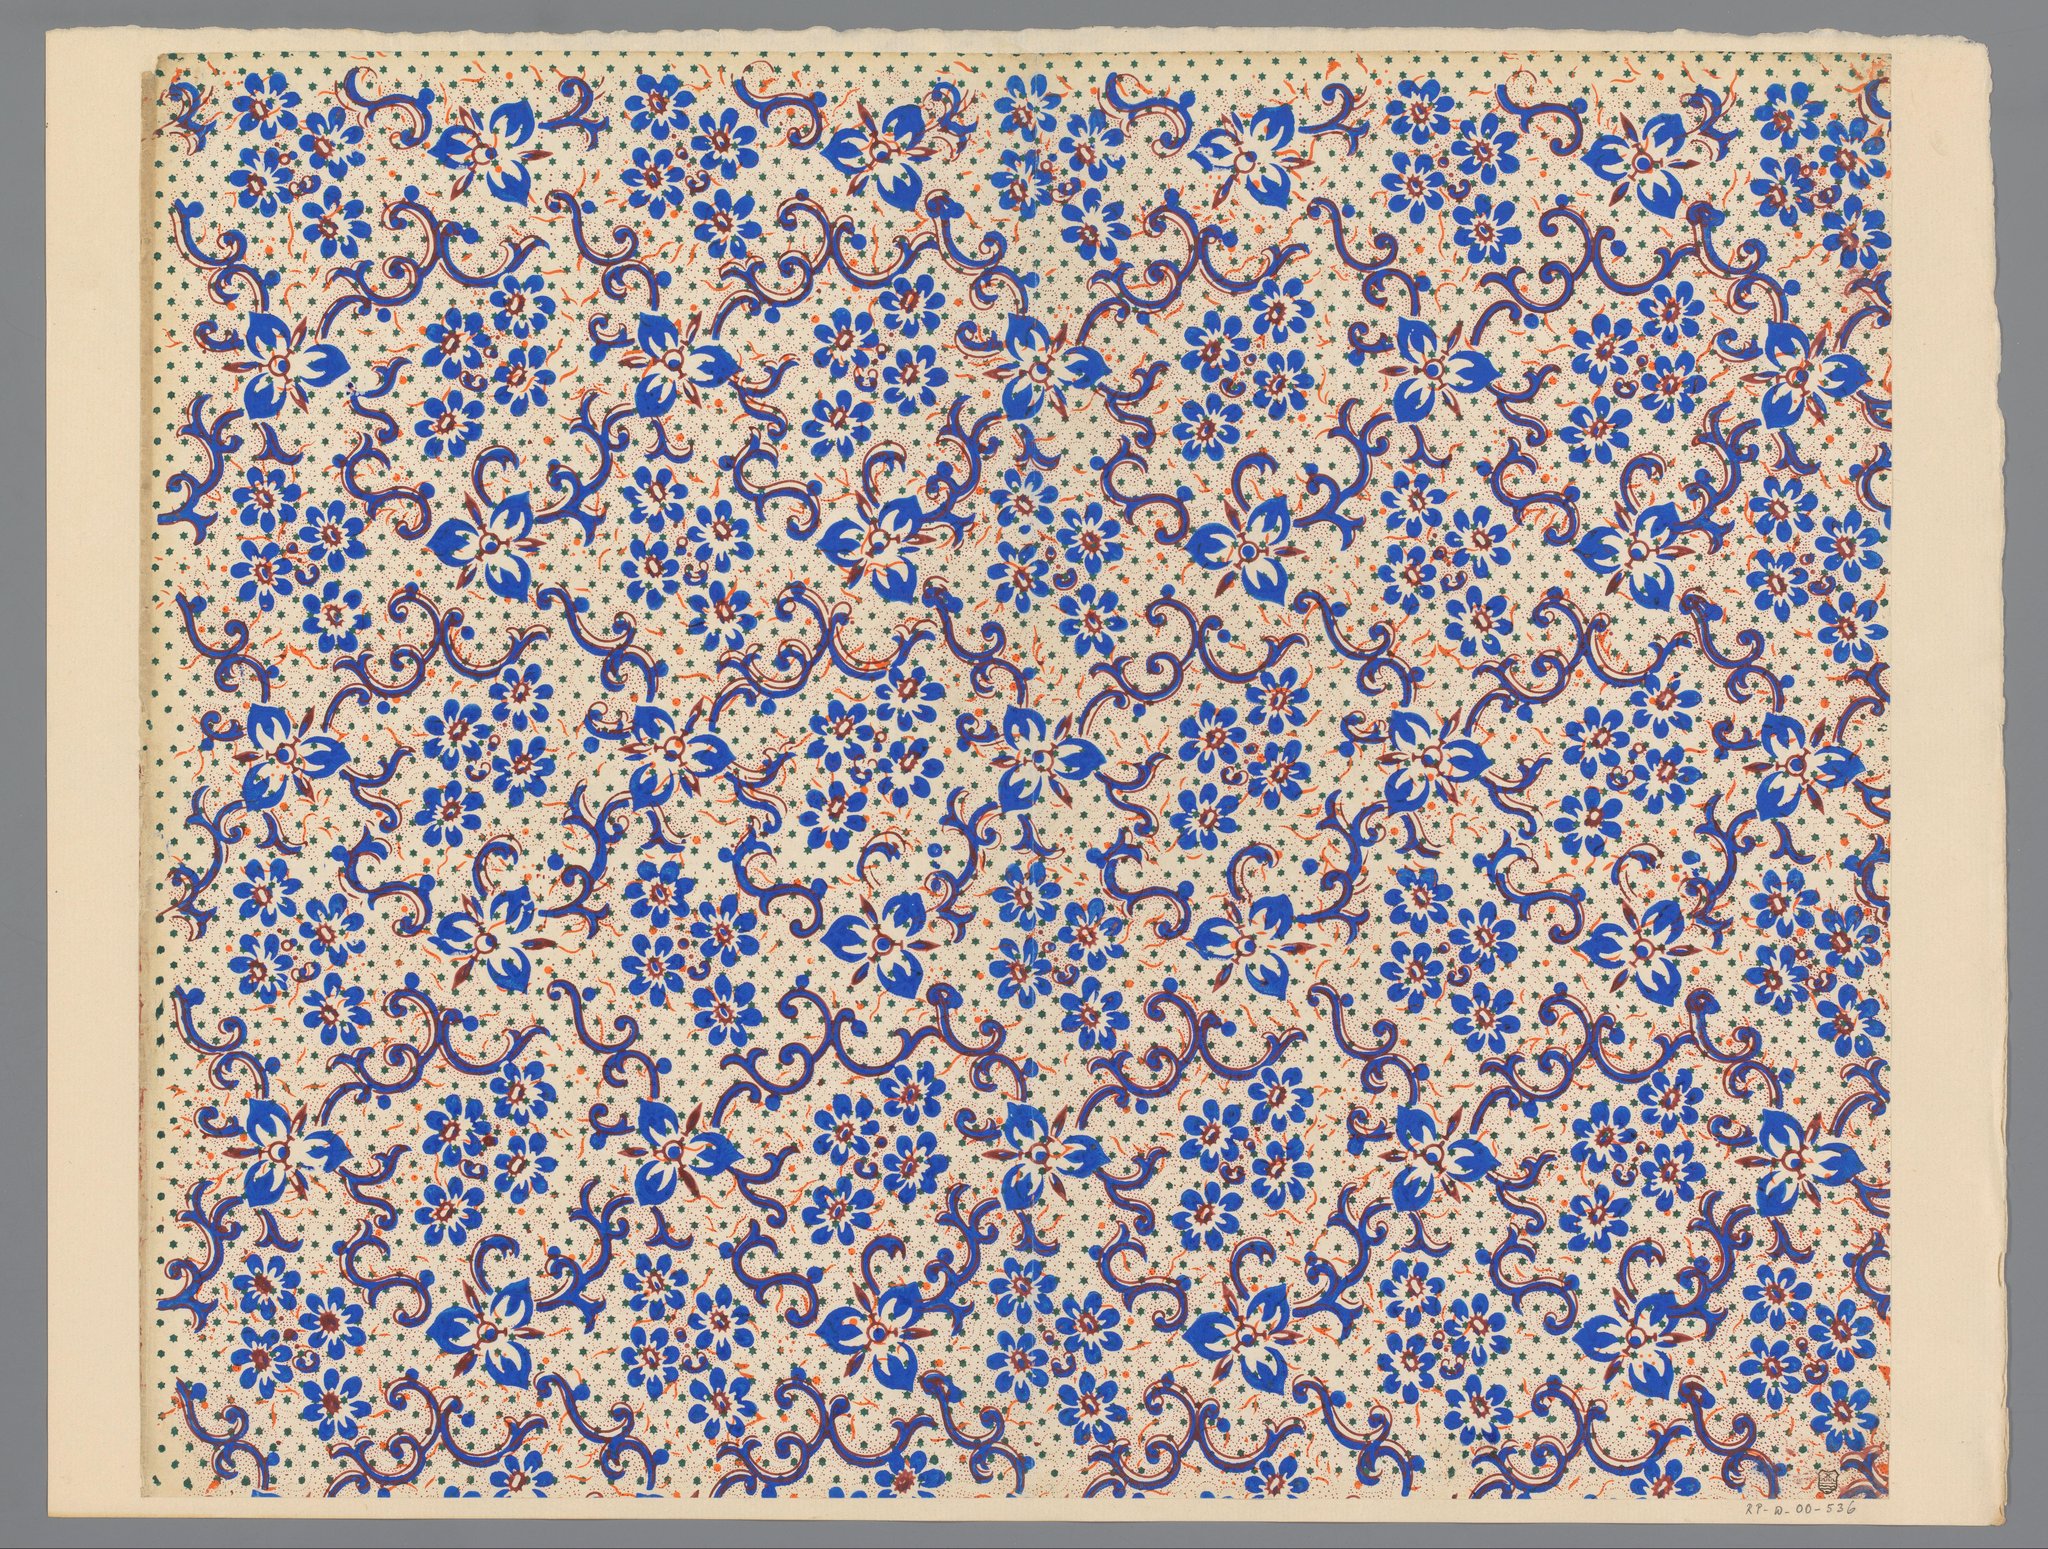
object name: printed paper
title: Blad met strooipatroon van bloemen en gestileerde ranken en met puntenfond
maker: Anonymous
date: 1800-1900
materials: paper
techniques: printing block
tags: ornament derived from plant forms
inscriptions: collector's mark: Lugt 2760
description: Blad met strooipatroon van bloemen en gestileerde ranken en sterretjes en streepjes met puntenfond.